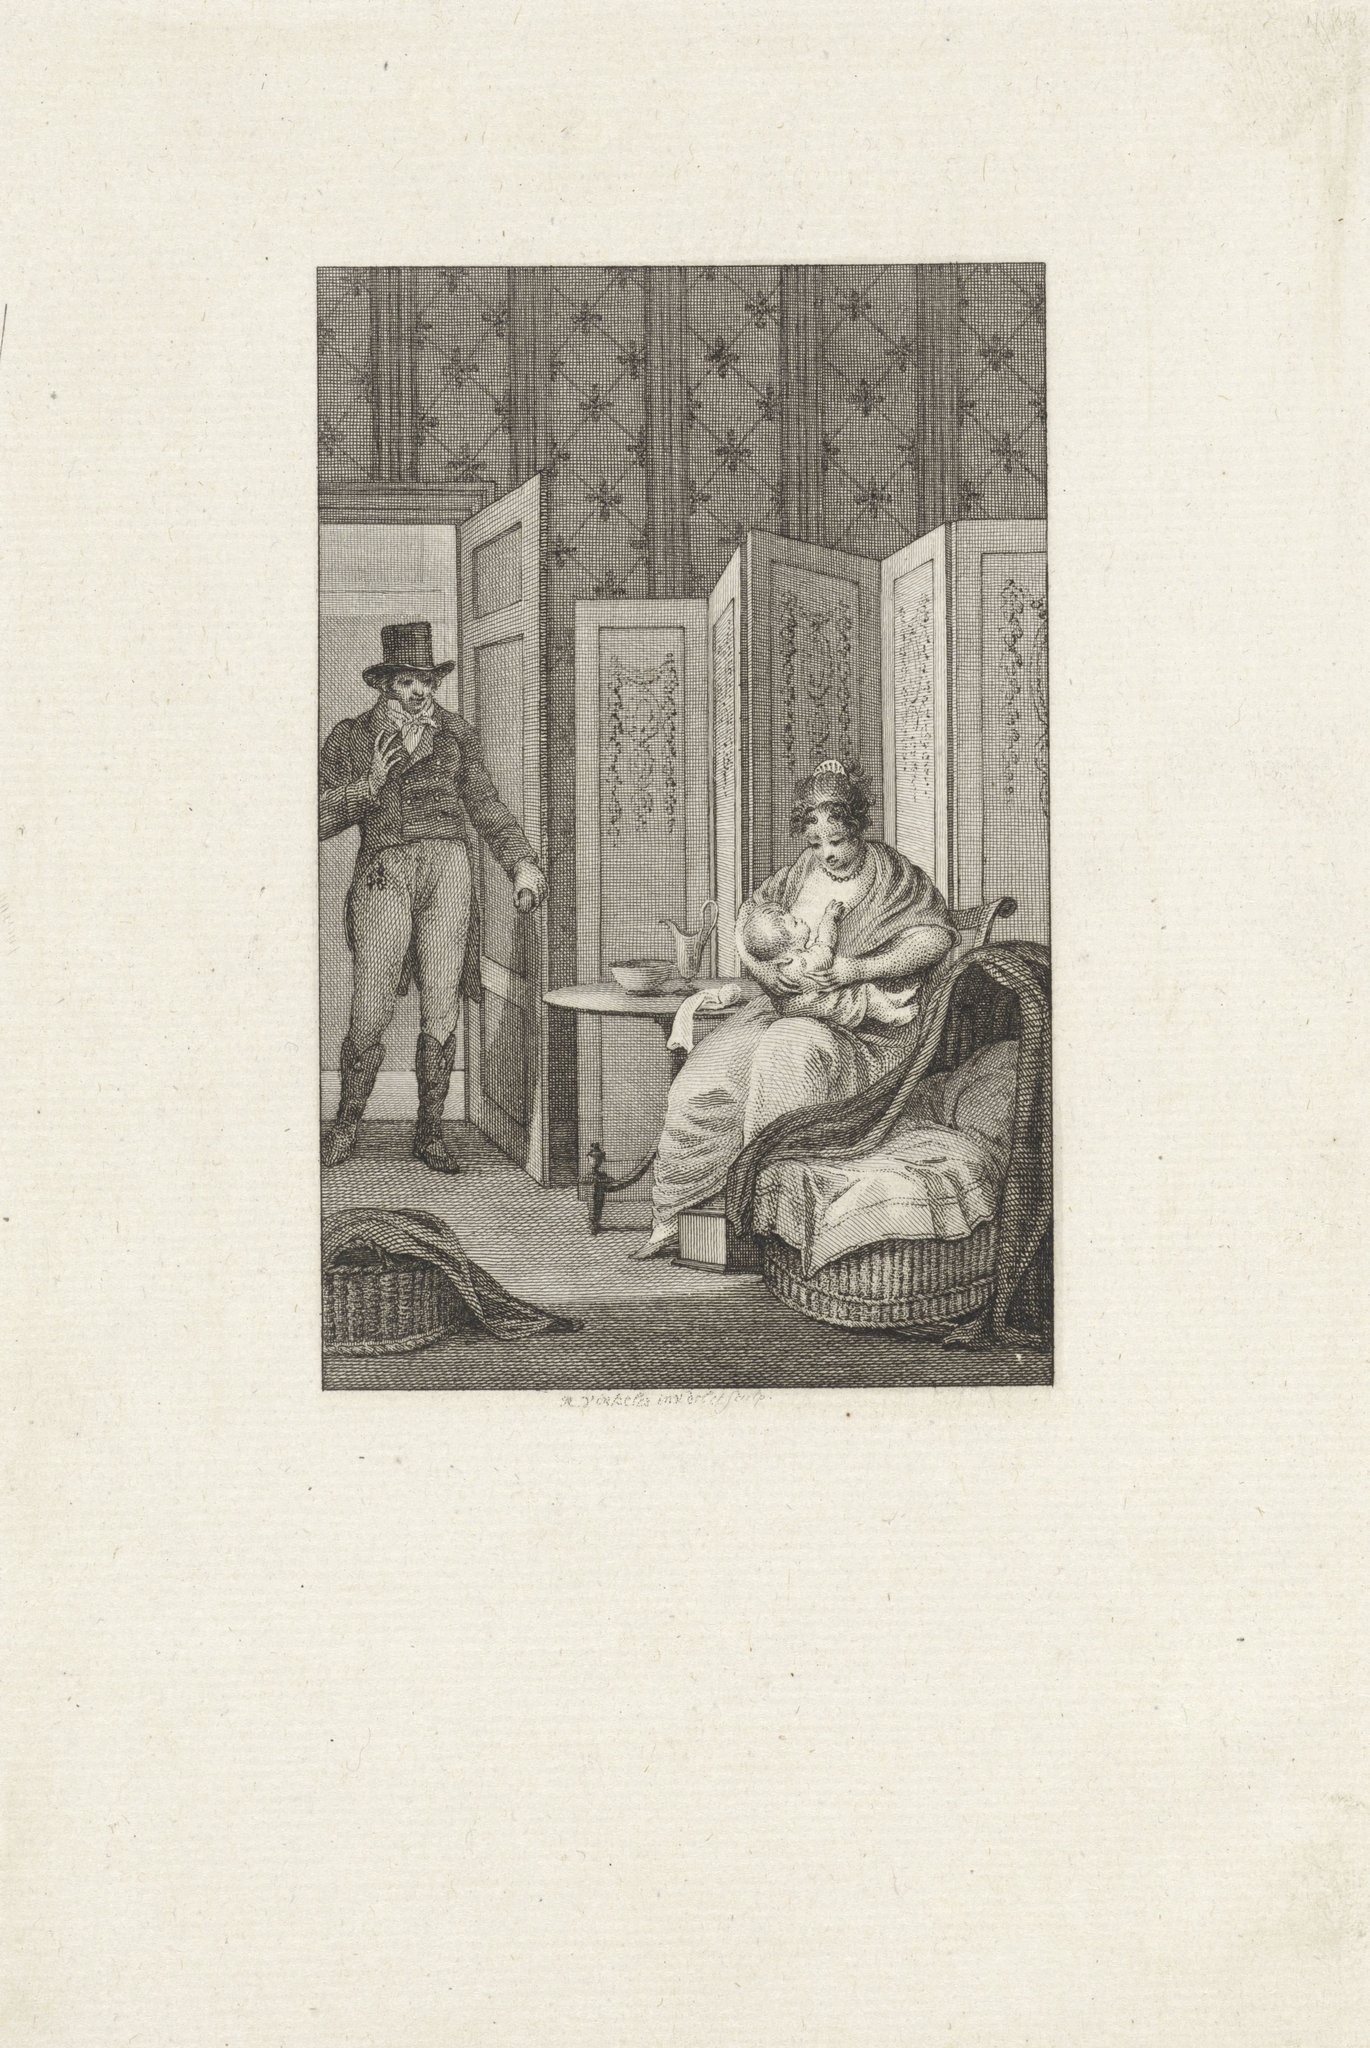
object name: print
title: Moeder met kind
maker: reinier vinkeles (i)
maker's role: draughtsman, print maker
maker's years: 1741-1816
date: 1809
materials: paper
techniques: engraving, etching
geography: amsterdam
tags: adult woman, mother and baby or young child, father-love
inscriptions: collector's mark: Lugt 2228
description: In een vertrek zit een moeder met haar kind op schoot. In de deuropening staat een man. De prent is een illustratie voor een boek over de vier 'tijdperken' van de vrouw, van het tijdperk 'de huismoeder'.